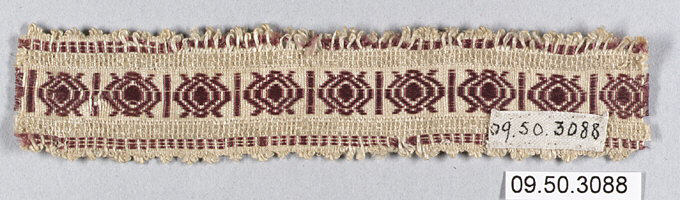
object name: gimp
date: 1701-1900